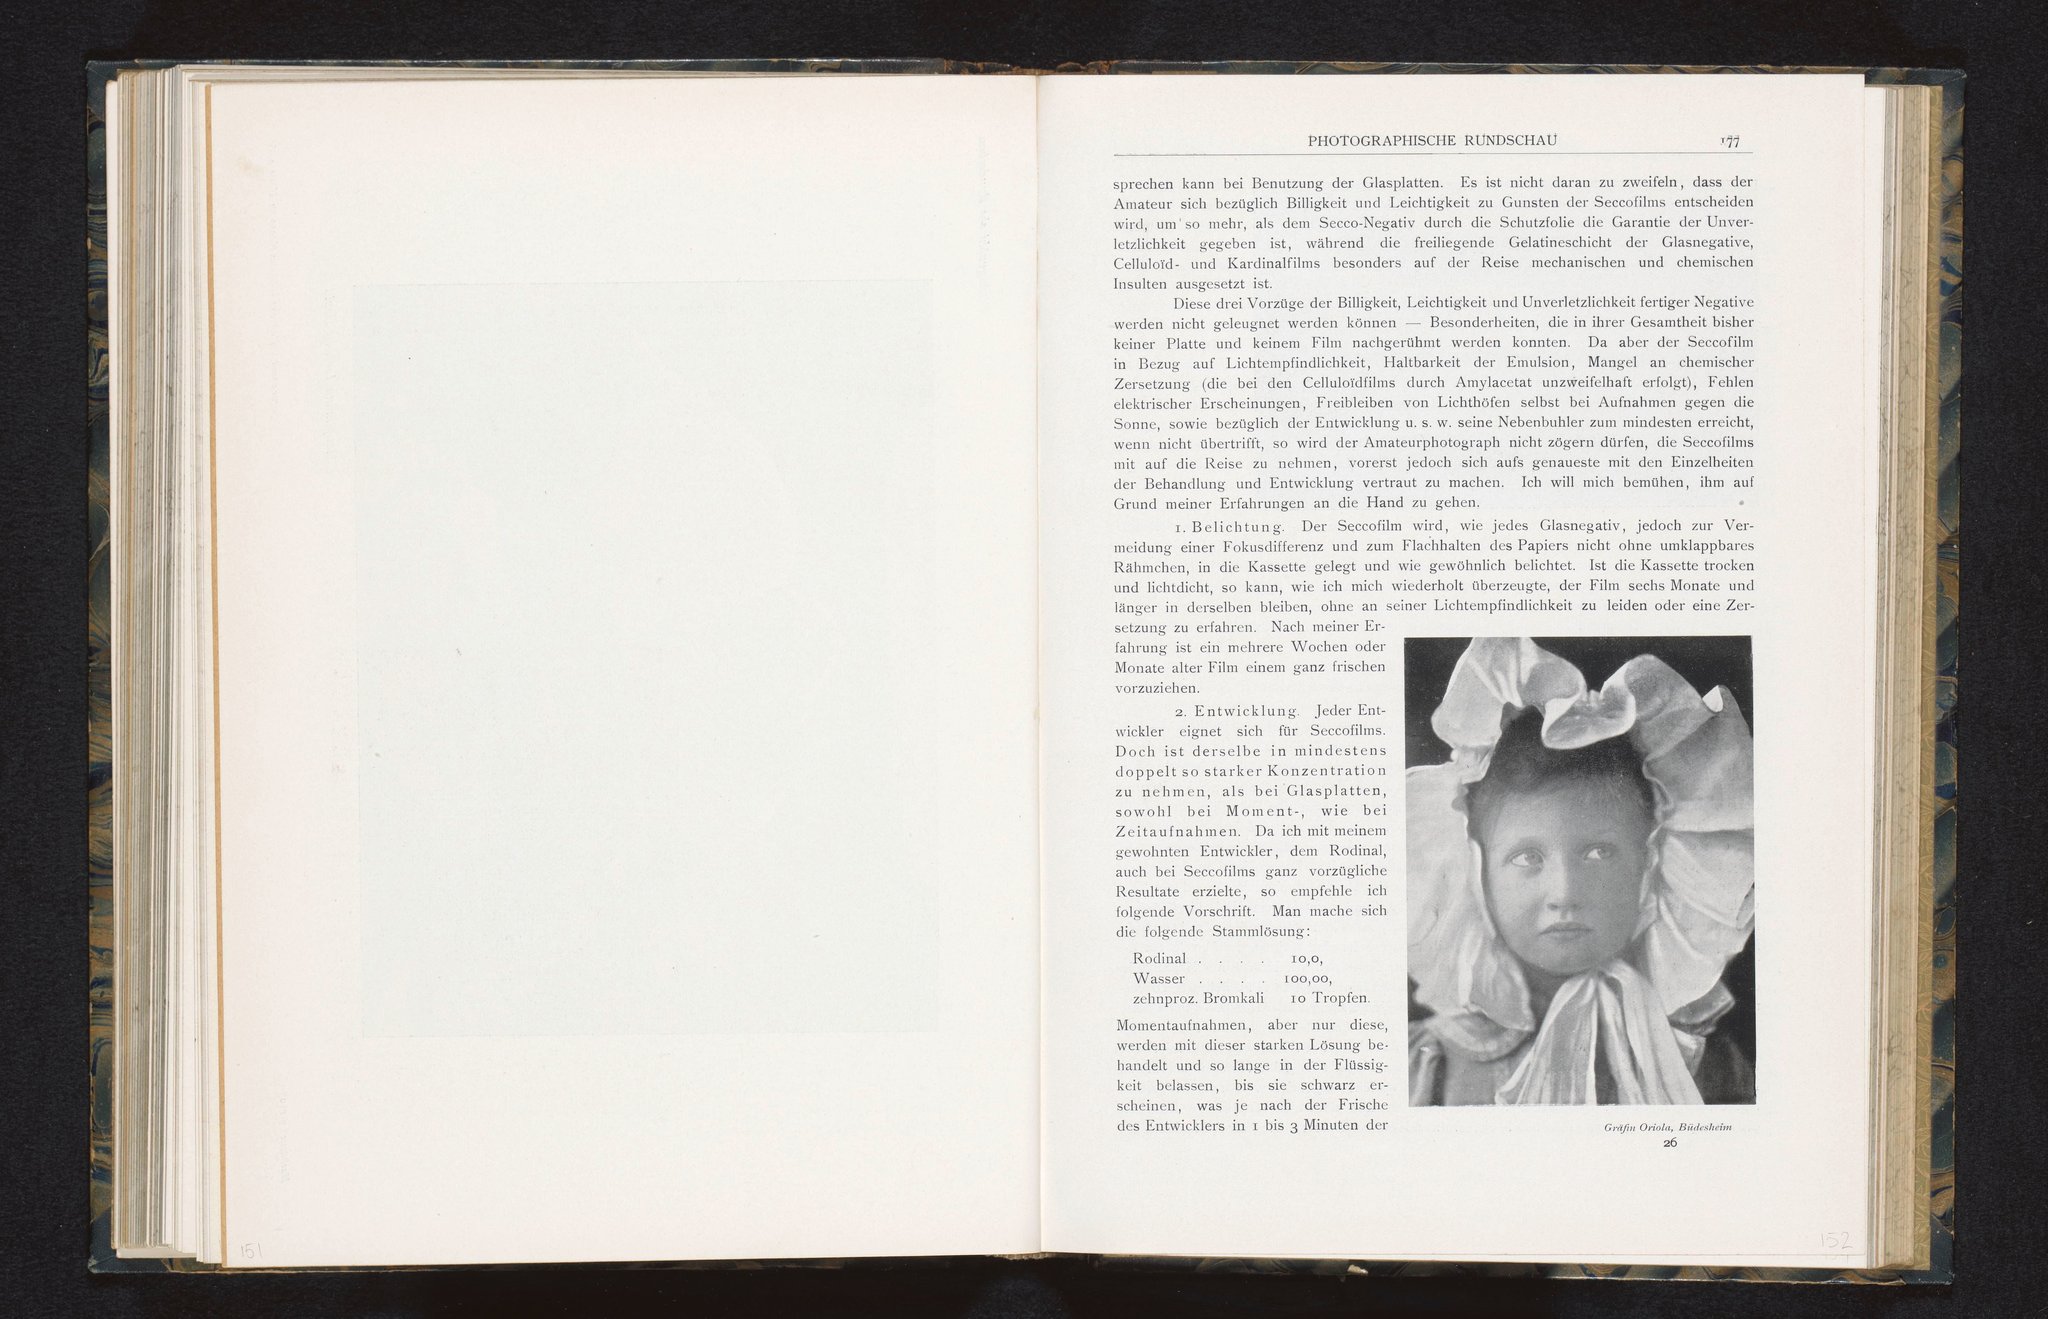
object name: page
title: Portret van een onbekend kind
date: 1895-1900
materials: paper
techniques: autotype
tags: child, anonymous historical person portrayed